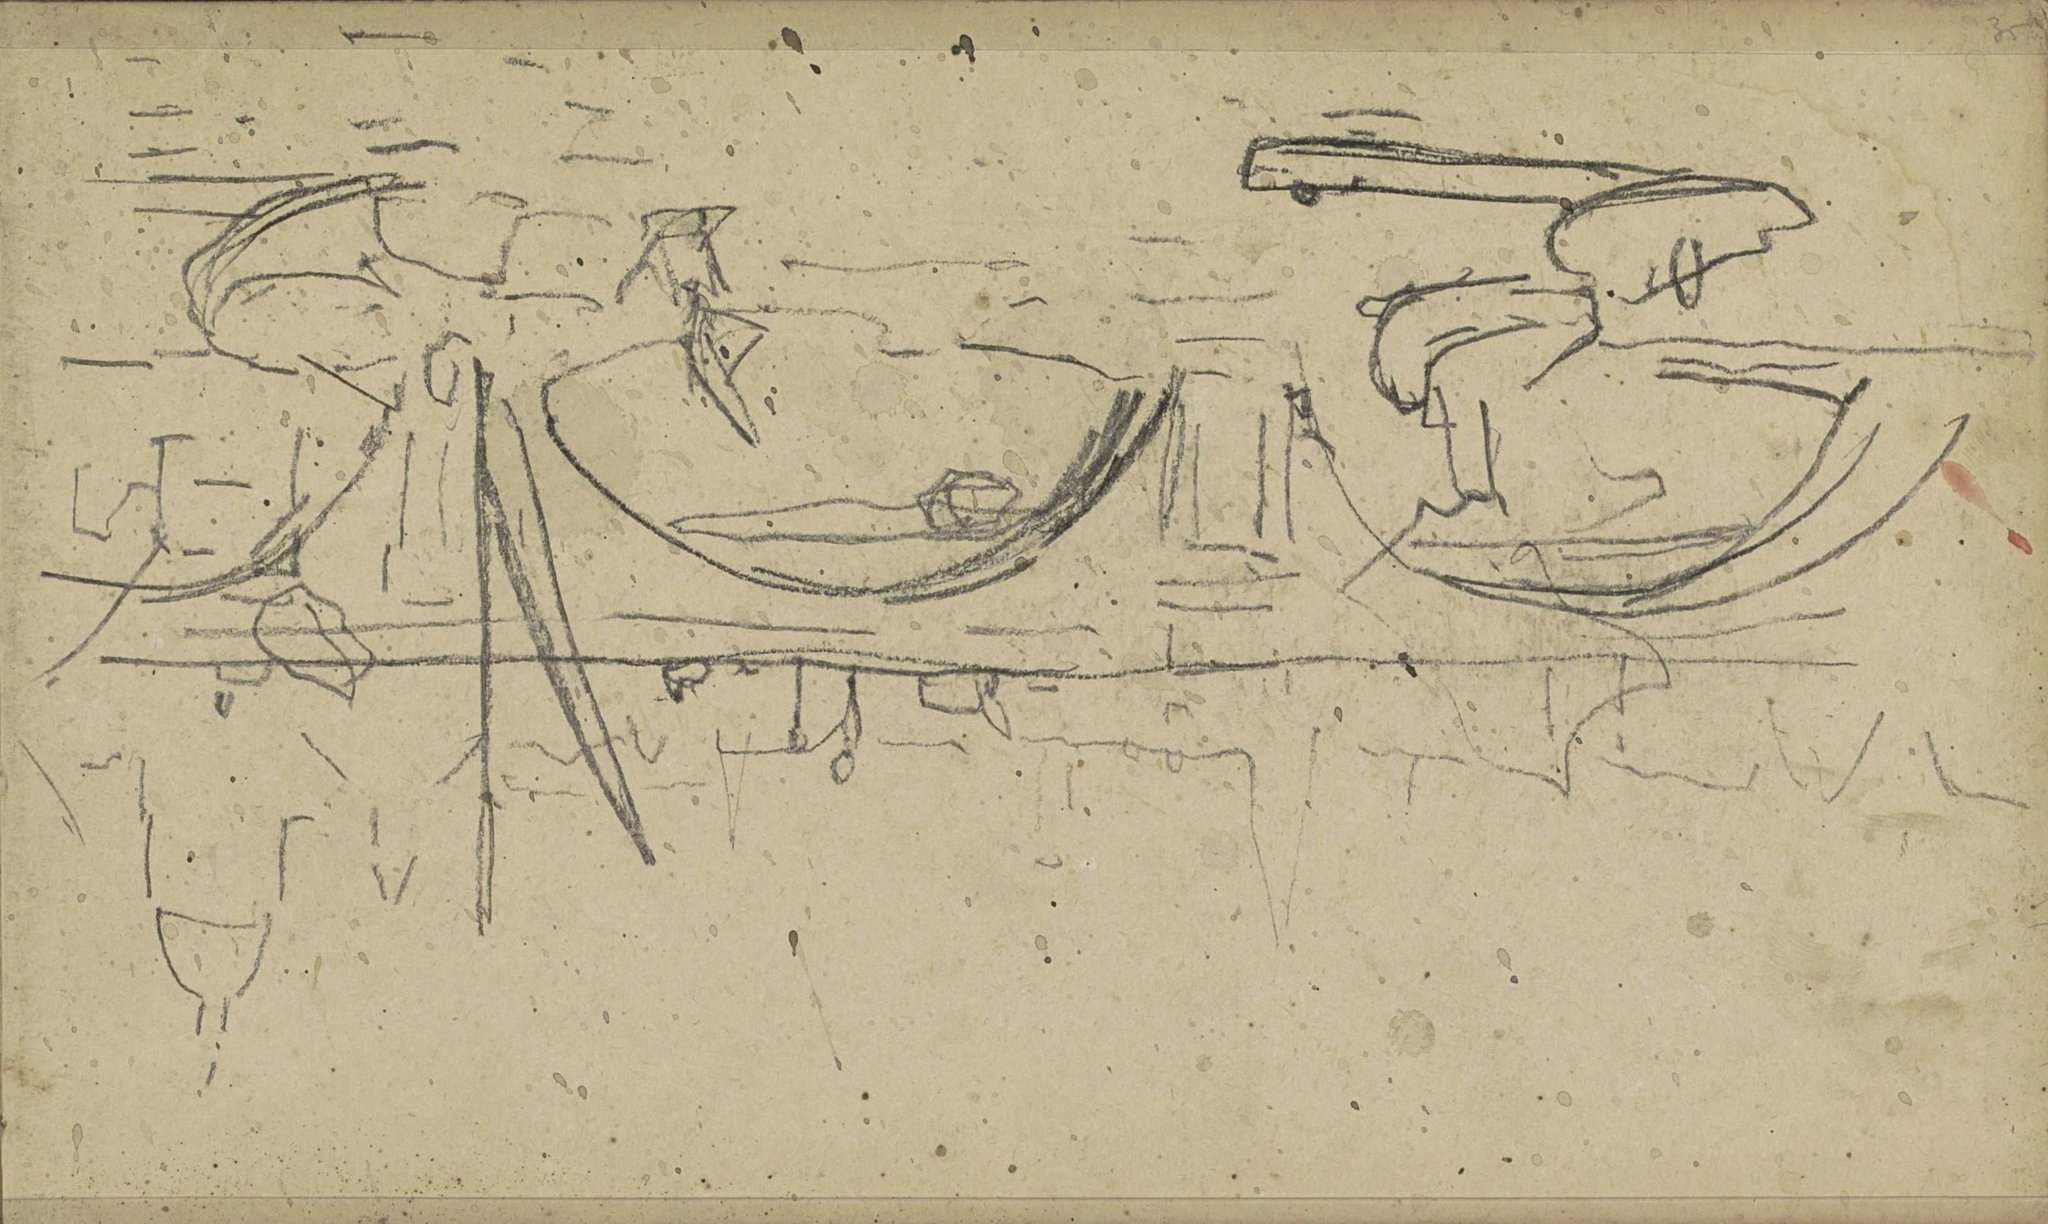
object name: sketchbook leaf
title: Gezicht op de Waterloo Bridge te Londen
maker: willem witsen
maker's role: draughtsman, painter, print maker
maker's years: 1860-1923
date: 1888-1891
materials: chalk, paper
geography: london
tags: ships (in general), church (exterior), bridge in city across river, canal, etc., thames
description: Pagina 35 uit een schetsboek met 27 bladen.